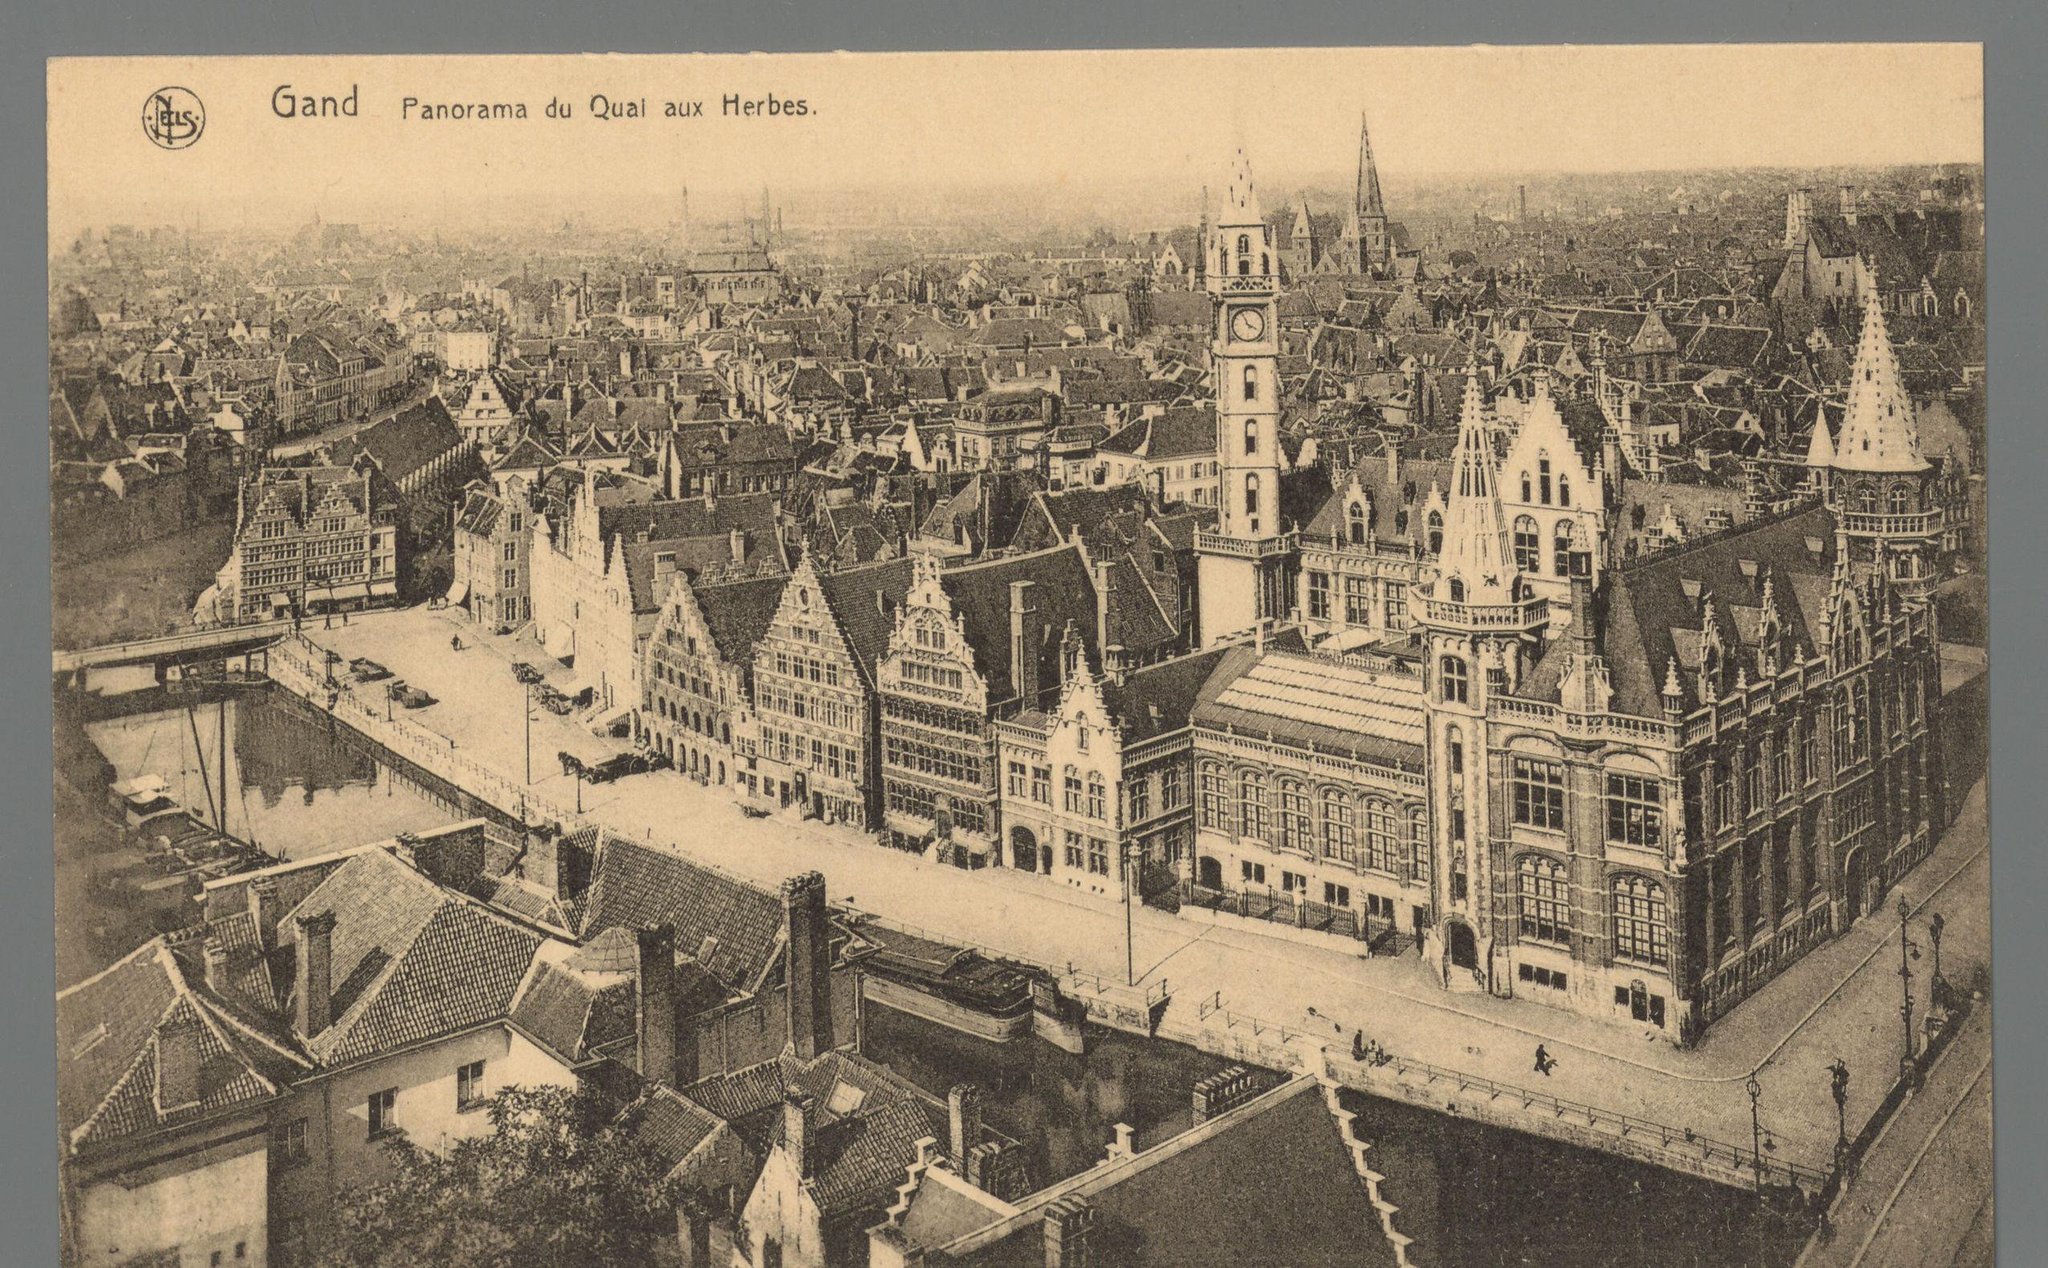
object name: ansichtkaart, prentbriefkaart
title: Gand. Panorama du Quai aux Herbes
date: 1913-1930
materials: cardboard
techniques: photograph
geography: ghent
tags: church (exterior), prospect of city, town panorama, silhouette of city, quay, ghent